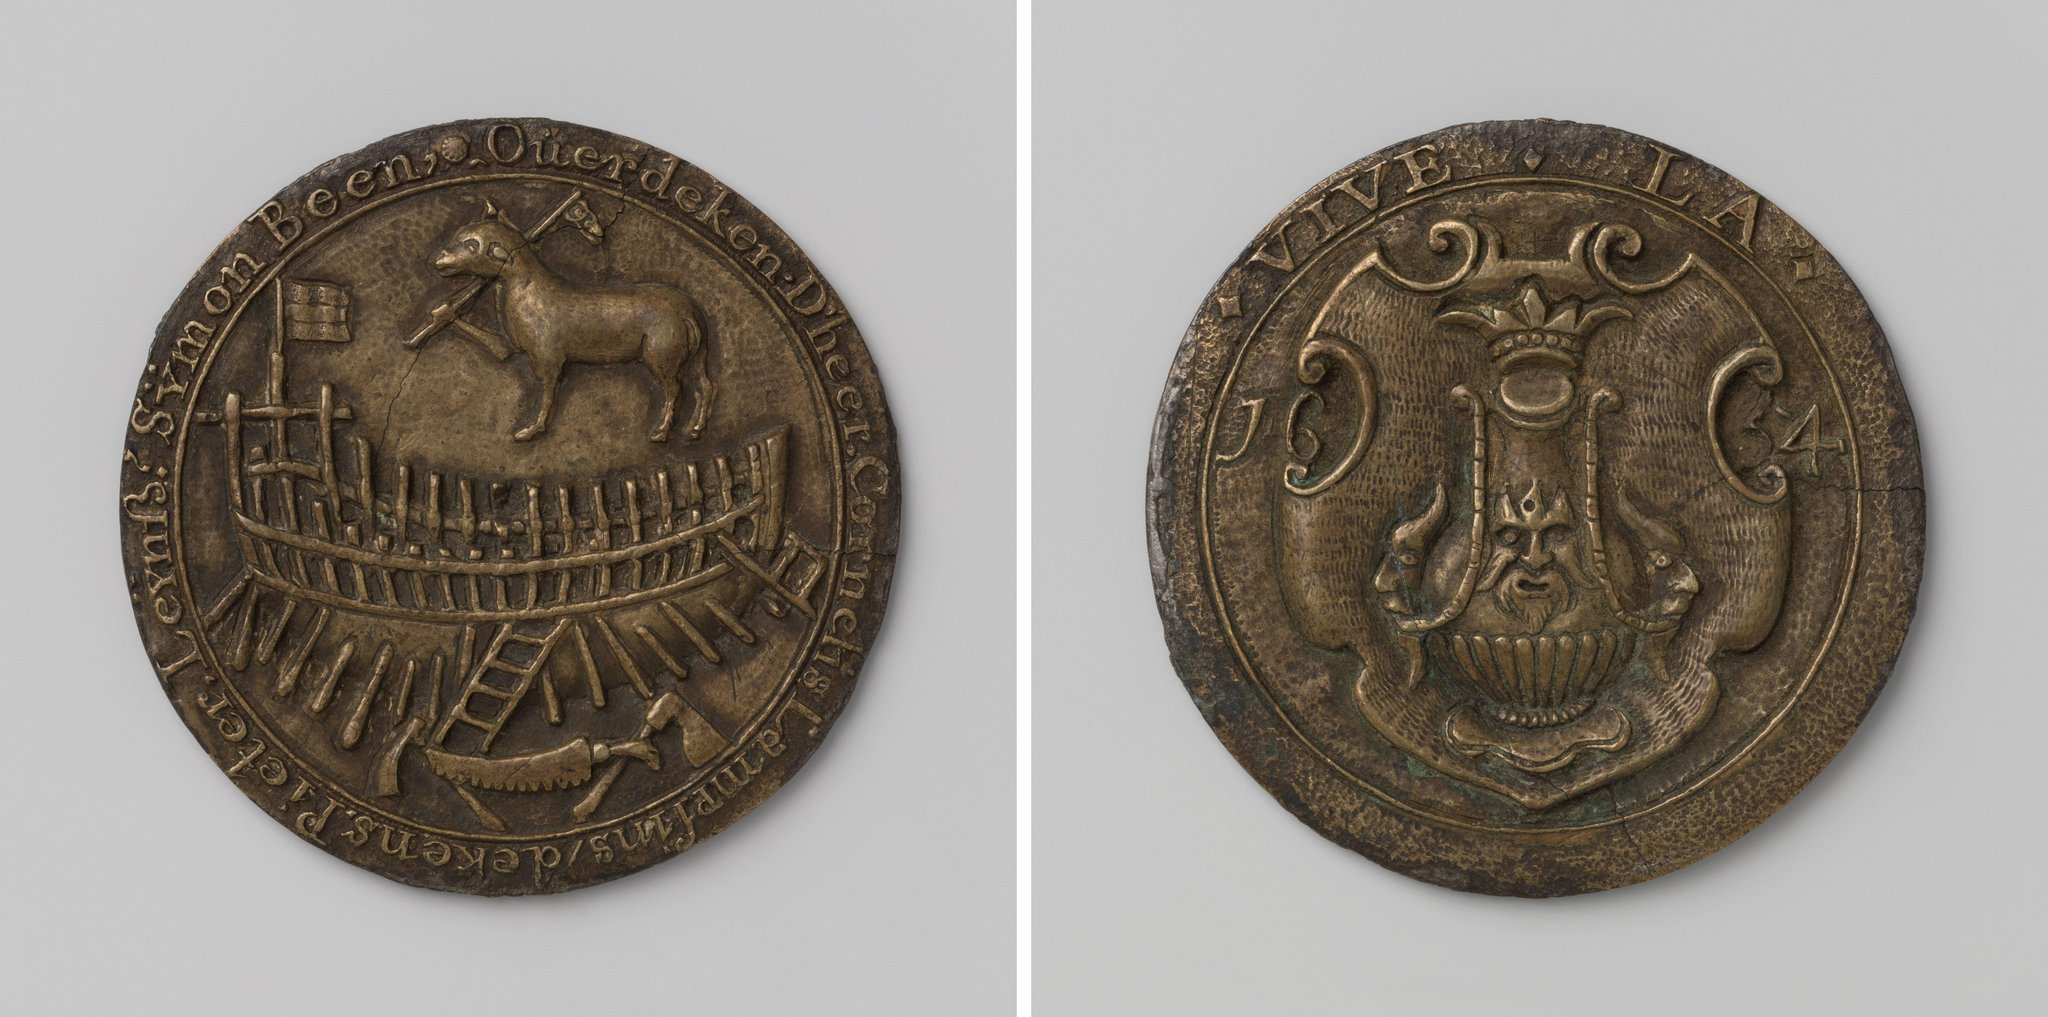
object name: medal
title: Scheepmakersgilde van Vlissingen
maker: Anonymous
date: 1654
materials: brass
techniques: casting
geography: flushing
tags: flushing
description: Messing penning. Voorzijde: schip in aanbouw met vlag op steven boven zaag tussen twee bijlen; boven schip: lam met vaandel binnen omschrift. Keerzijde: gekroonde fles met aan voorzijde en beide zijkanten afbeelding in relief van gezicht in cartouche tussen jaartal binnen omschrift